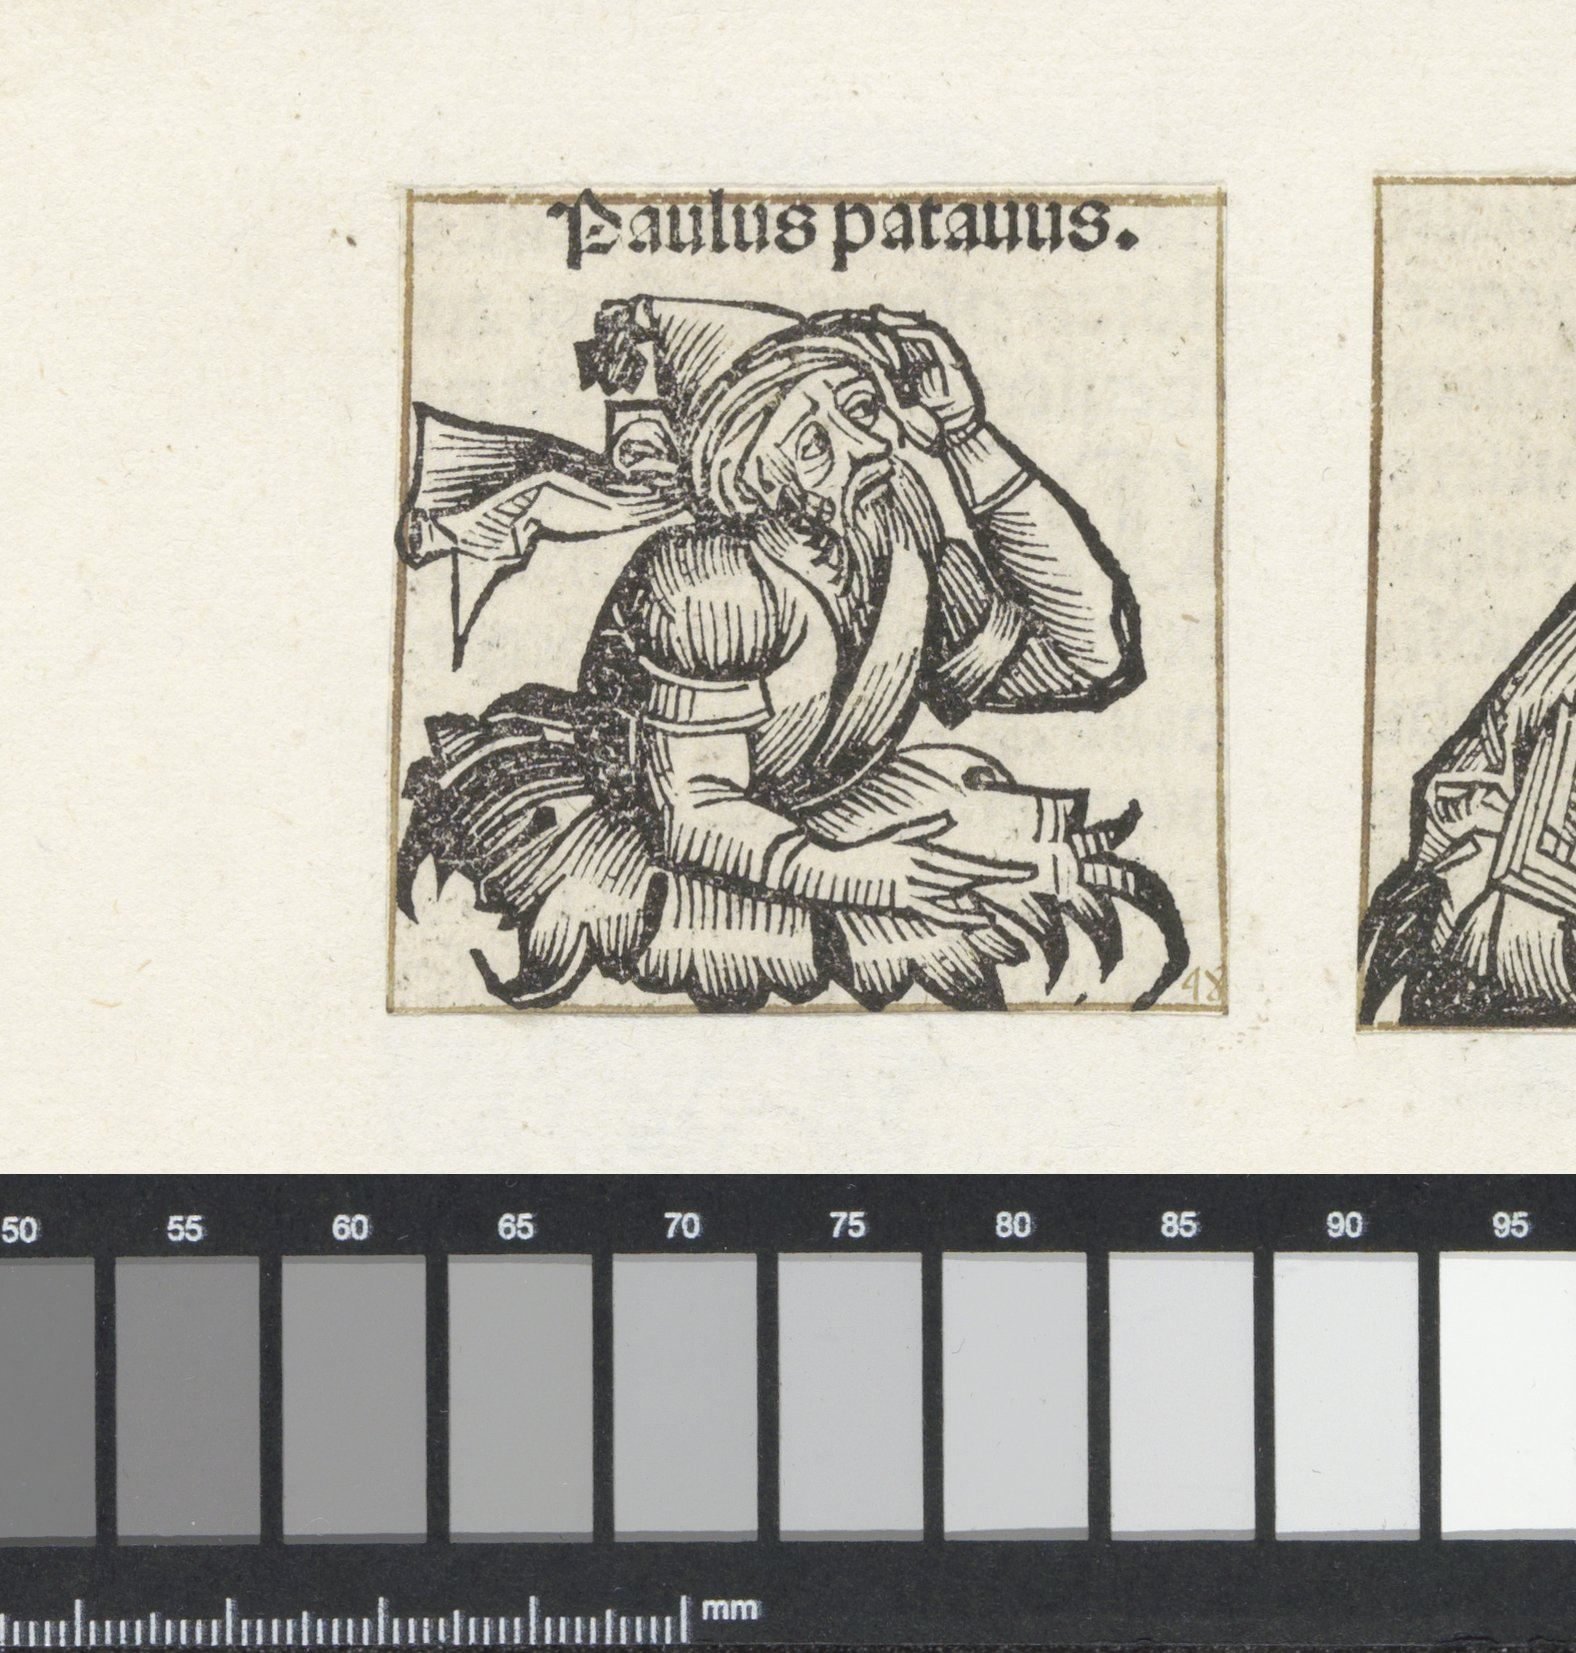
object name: print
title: Julius Paulus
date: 1493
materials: paper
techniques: letterpress printing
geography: nuremberg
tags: male persons from classical history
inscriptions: inscription: ‘48’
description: De houtsnede wordt herhaaldelijk gebruikt als boekillustratie in de Liber Chronicarum (of Neurenbergkroniek) van Hartmann Schedel, verschenen in het Latijn en Duits in 1493. Zie de Latijnse uitgave, folio 117v.